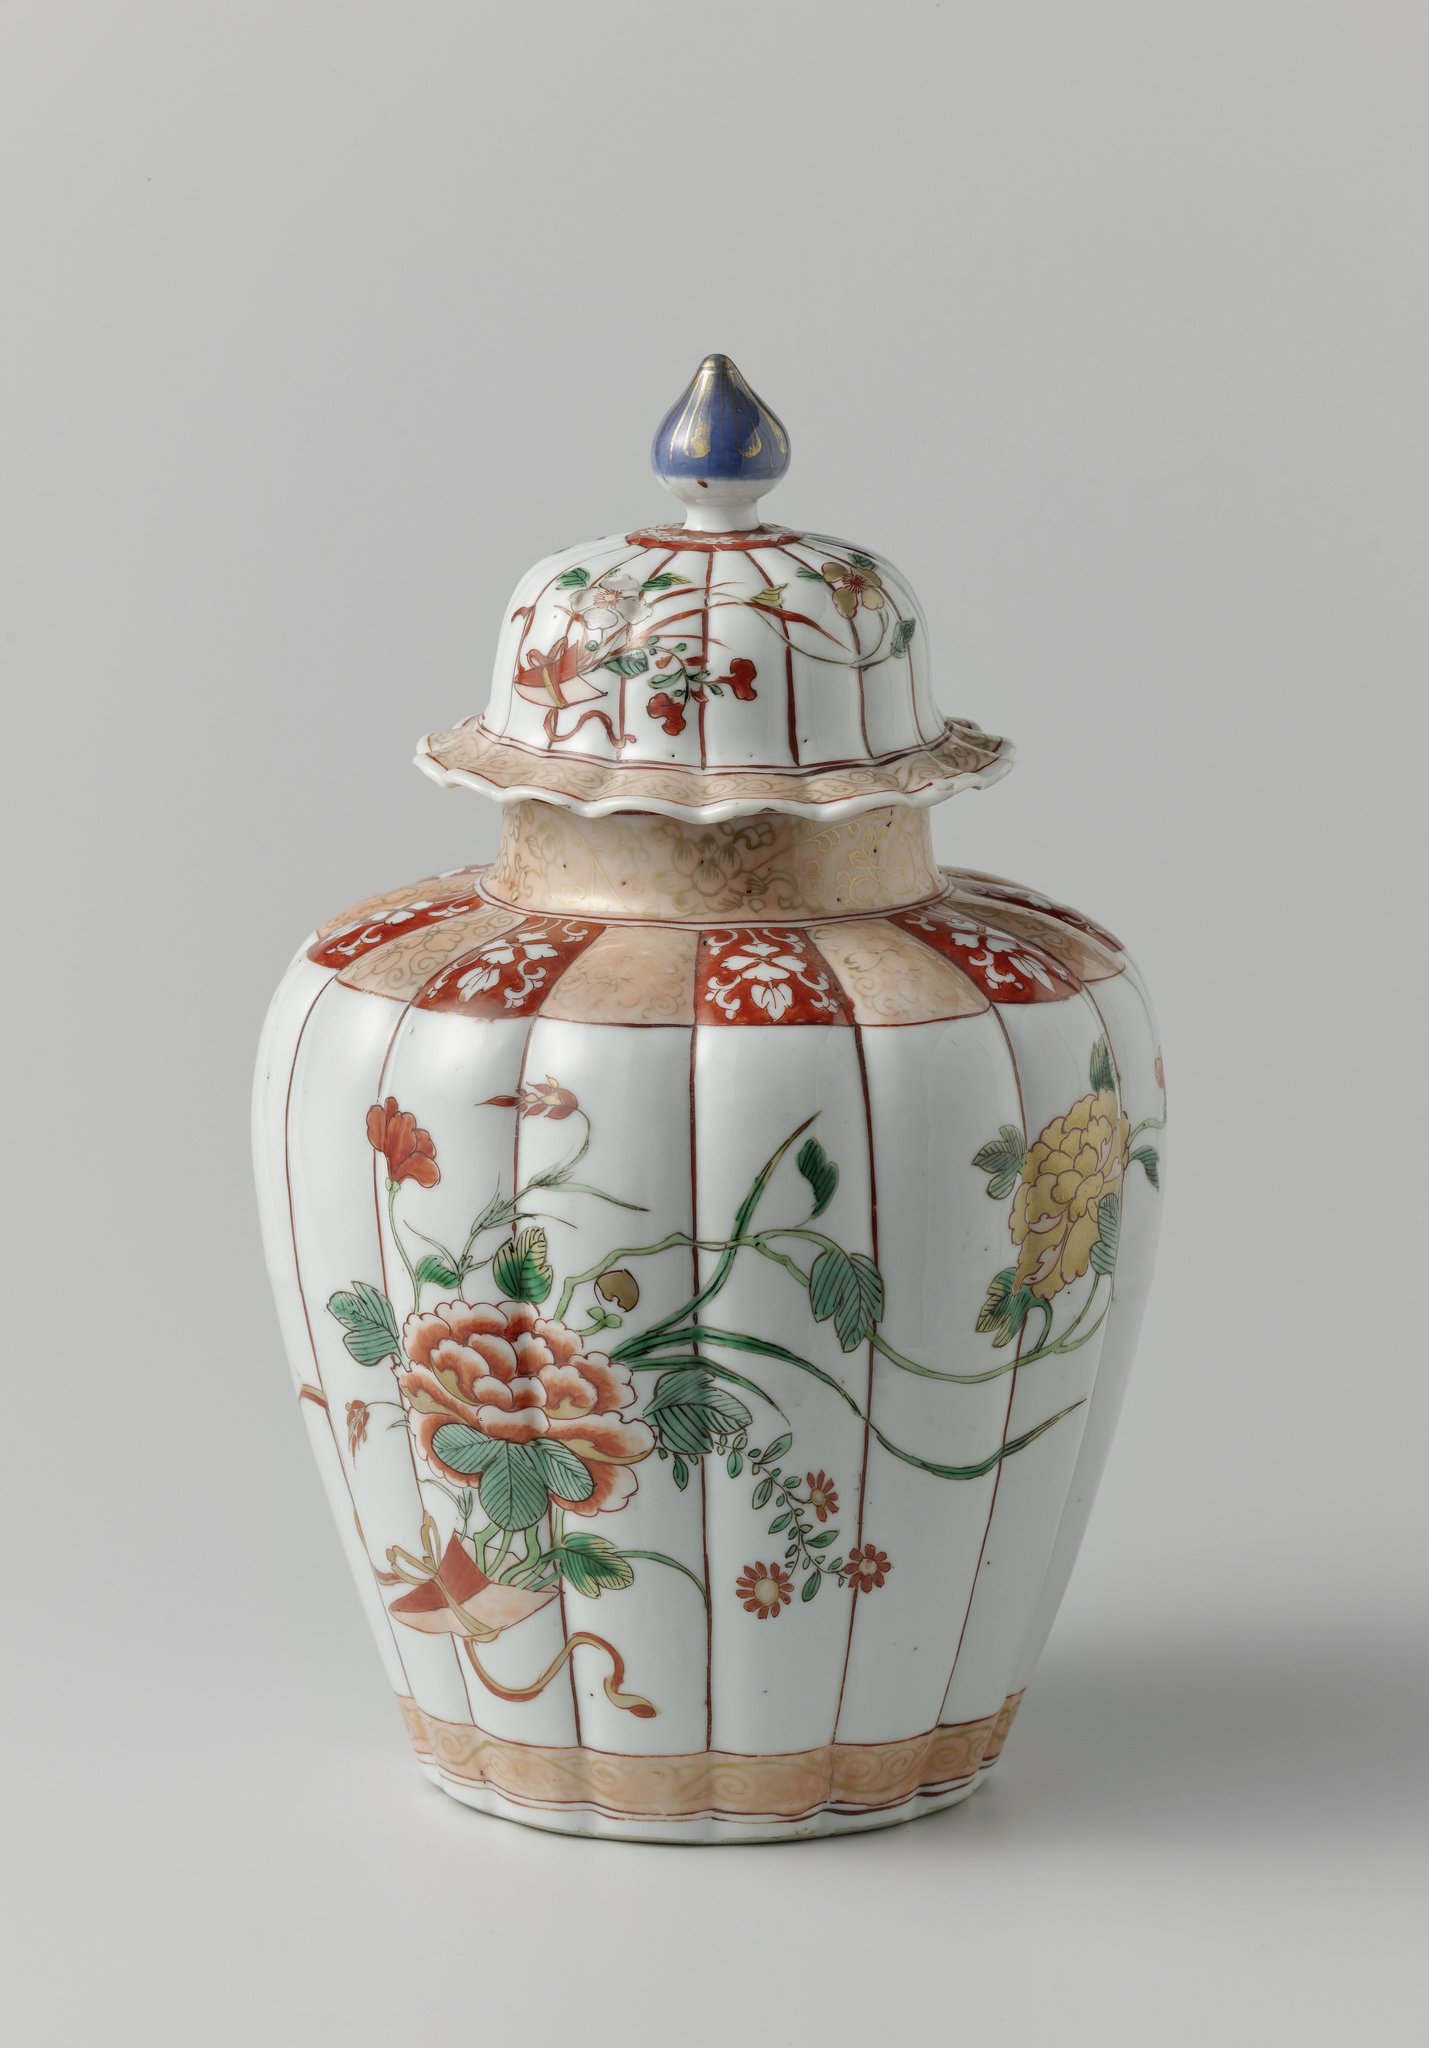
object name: pot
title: Lobed covered jar with two bouquets and flower scrolls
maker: Anonymous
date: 1725-1735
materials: cobalt, glaze, gold, paint, porcelain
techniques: forming, gilding, turning, vitrification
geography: china